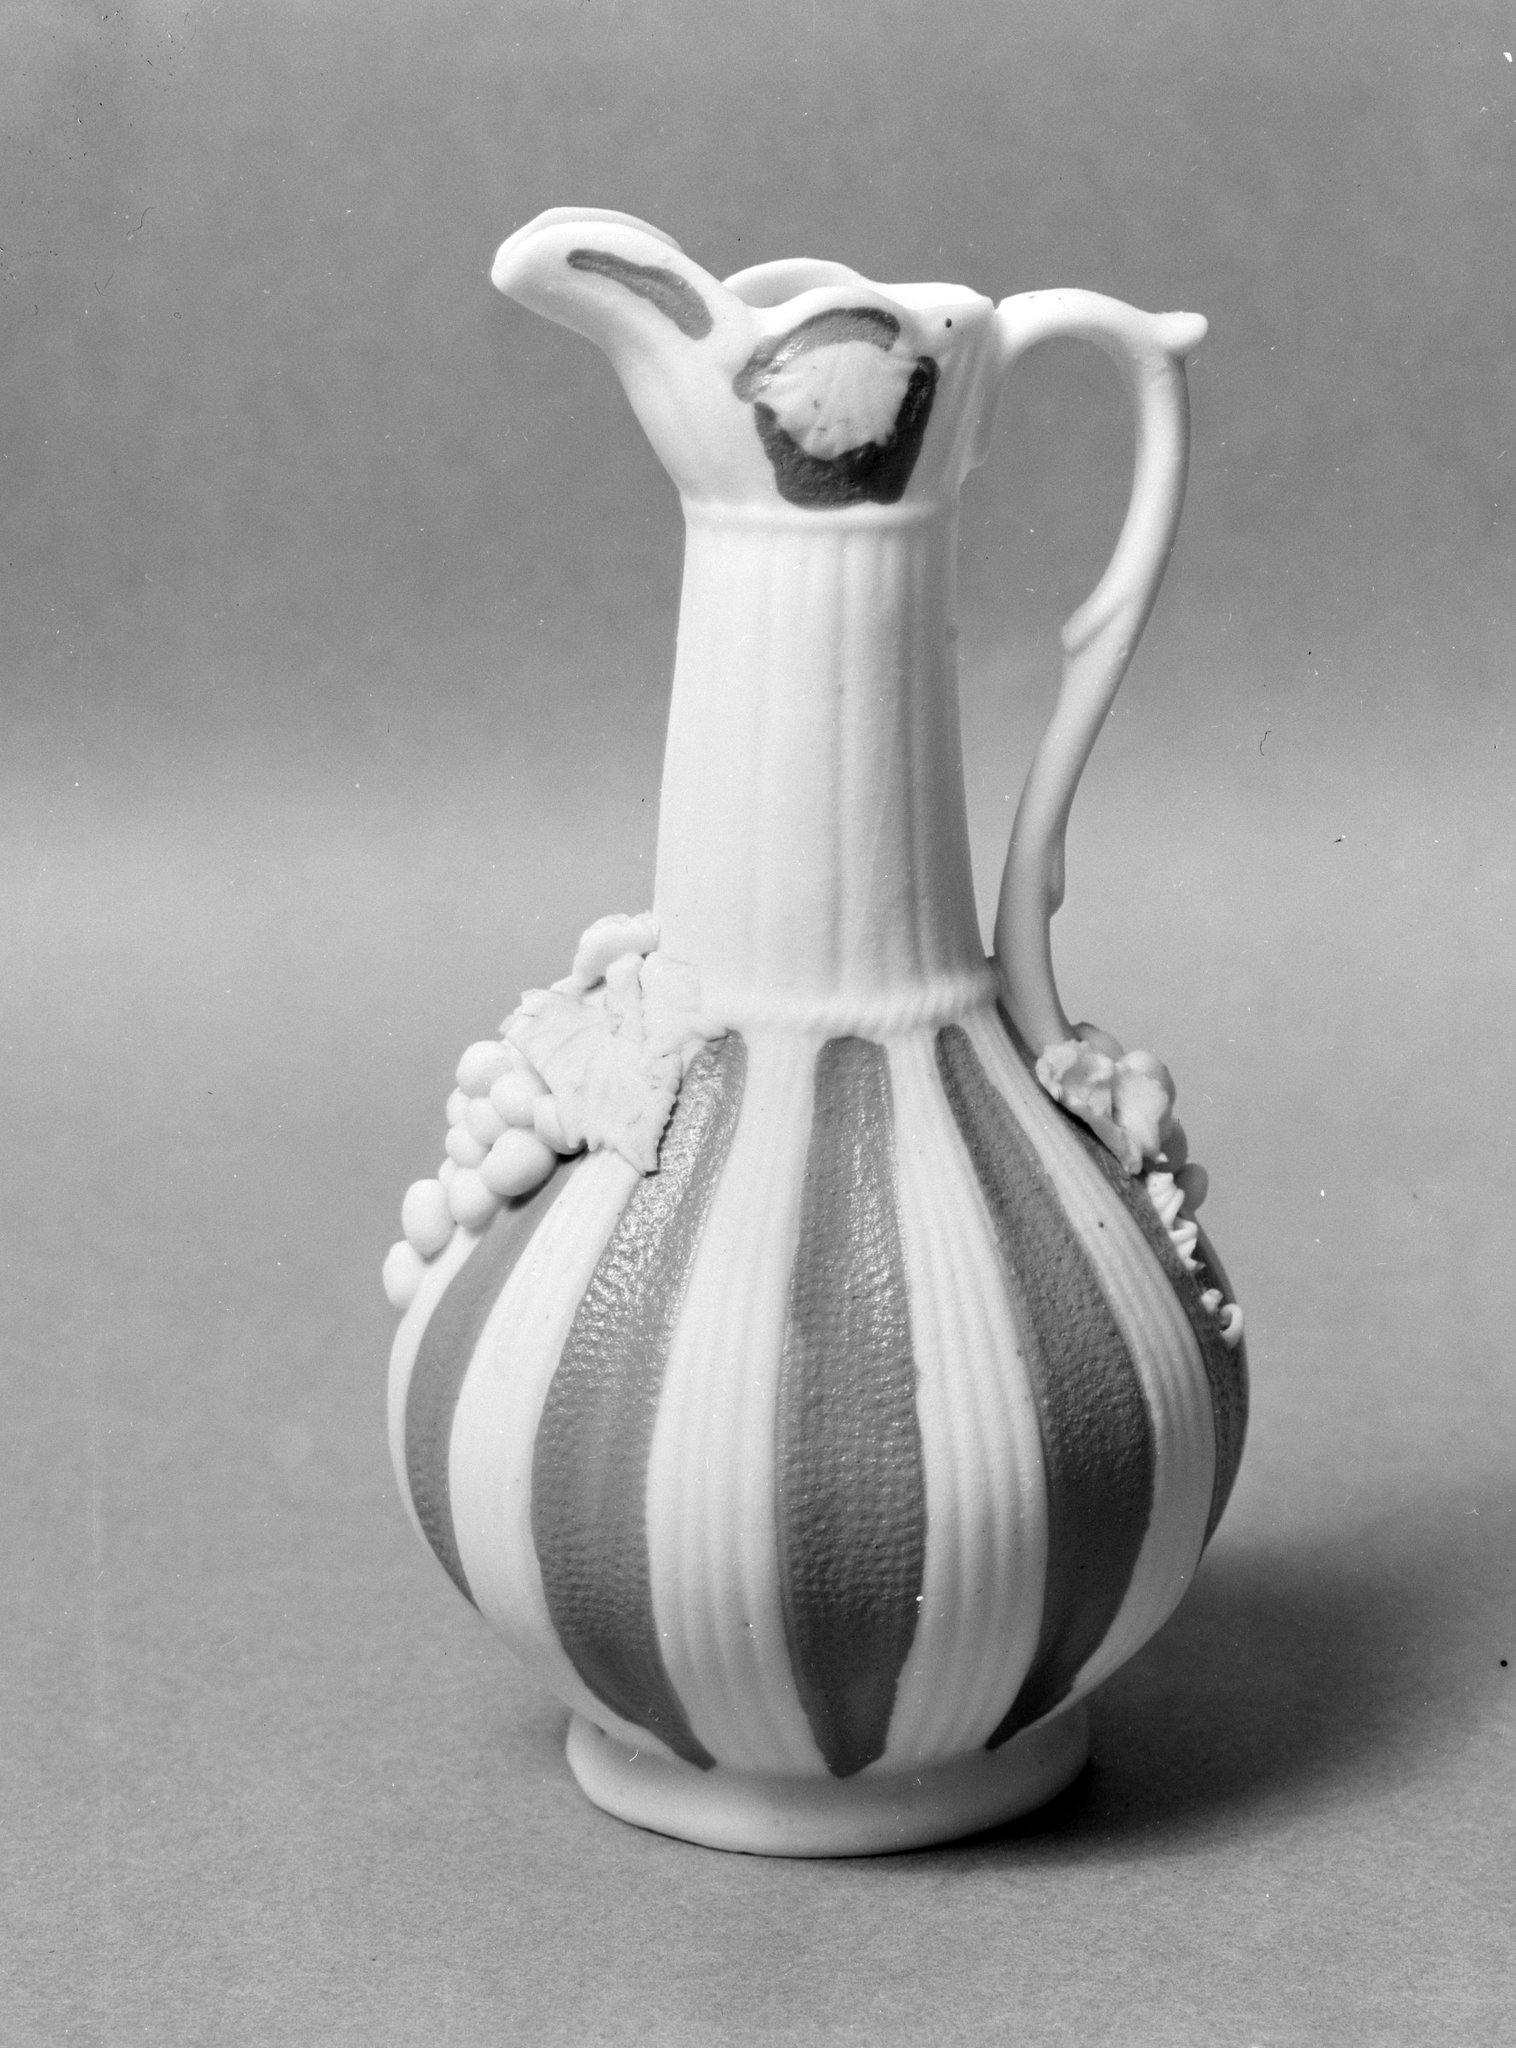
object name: ewer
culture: american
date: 1830-1870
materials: porcelain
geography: united states